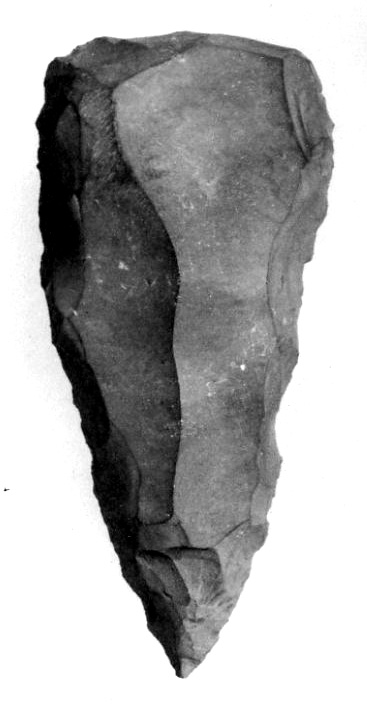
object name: tool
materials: stone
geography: egypt